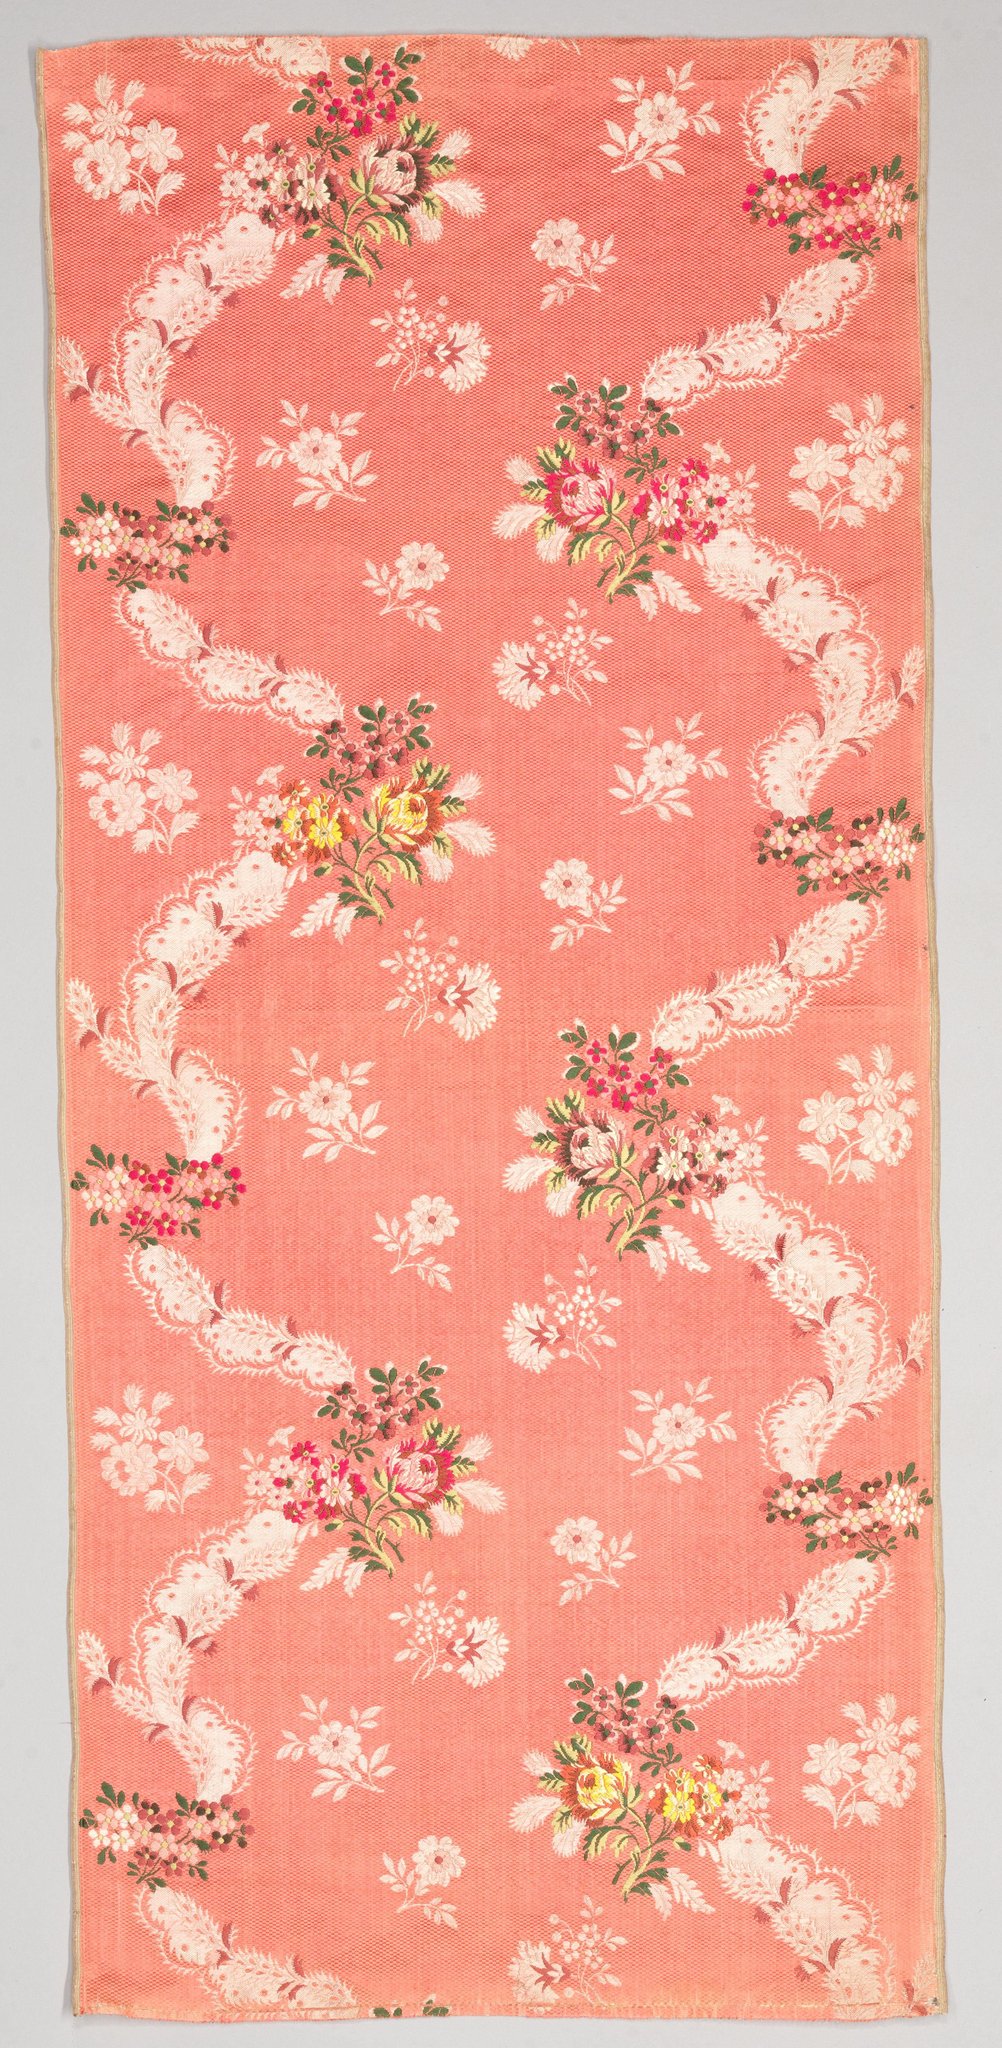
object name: baan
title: Baan zijdeweefsel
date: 1765-1770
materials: silk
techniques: brocade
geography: france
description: Baan zijdeweefsel. Dessin: in paralelle golven, omhooglopende kantbanden in wit met opgelegde bladeren in twee kleuren lila met in de wendingen afwisselend een veelkleurig boeket met verschillende bloemen en een boeket met kleine van wit naar paars verlopende bloemen waartussen witte struikbloemen op een roze fond. Toestand: goed.